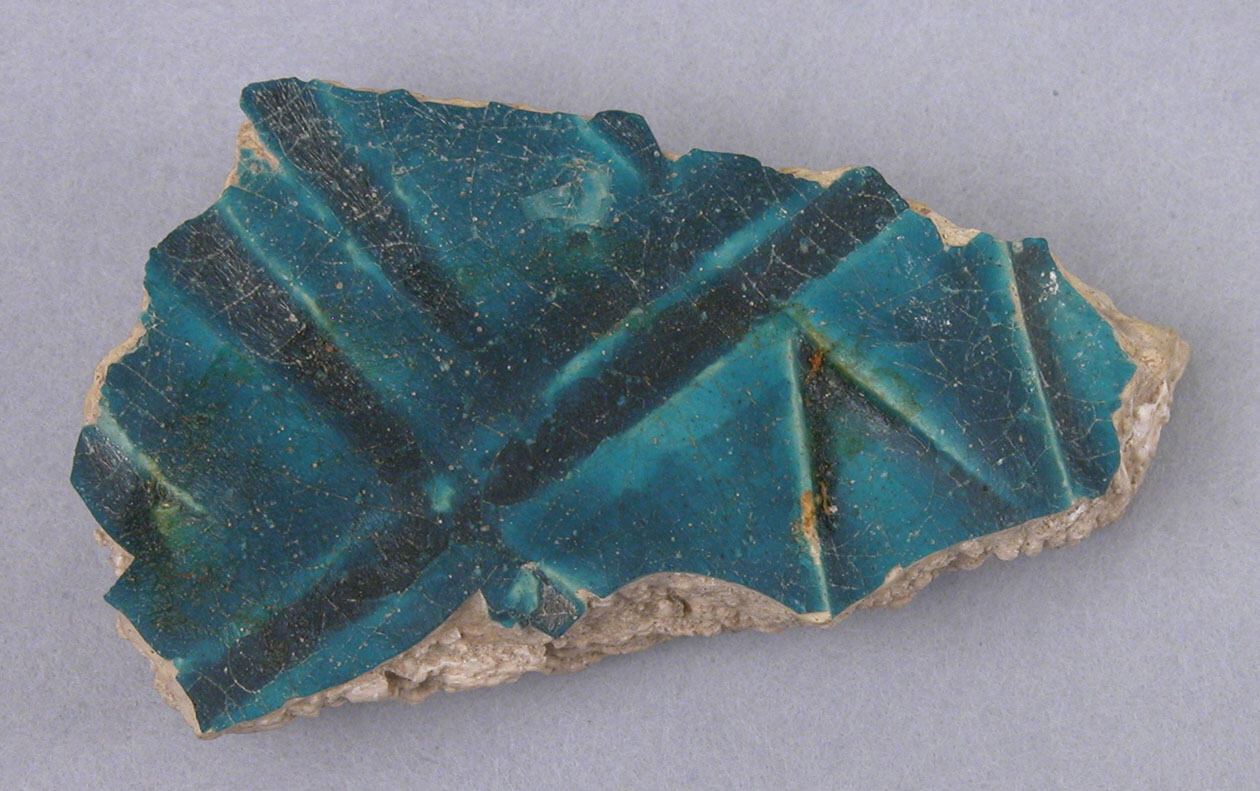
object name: fragment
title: Ceramic Fragment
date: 801-1000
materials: earthenware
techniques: glazing, molding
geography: saudi arabia